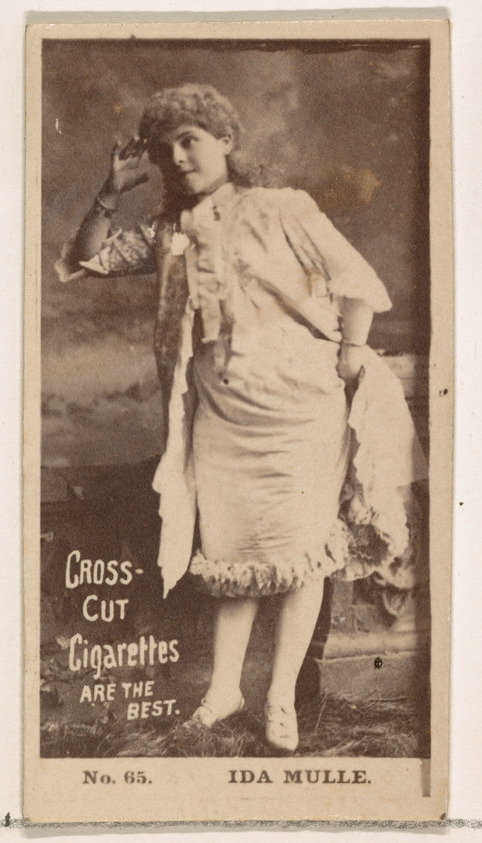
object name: print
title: Card Number 65, Ida Mulle, from the Actors and Actresses series (N145-2) issued by Duke Sons & Co. to promote Cross Cut Cigarettes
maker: w. duke, sons & co.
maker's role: publisher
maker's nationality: american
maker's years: 1870-1920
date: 1880-1889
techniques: albumen silver print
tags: portraits,women,actresses